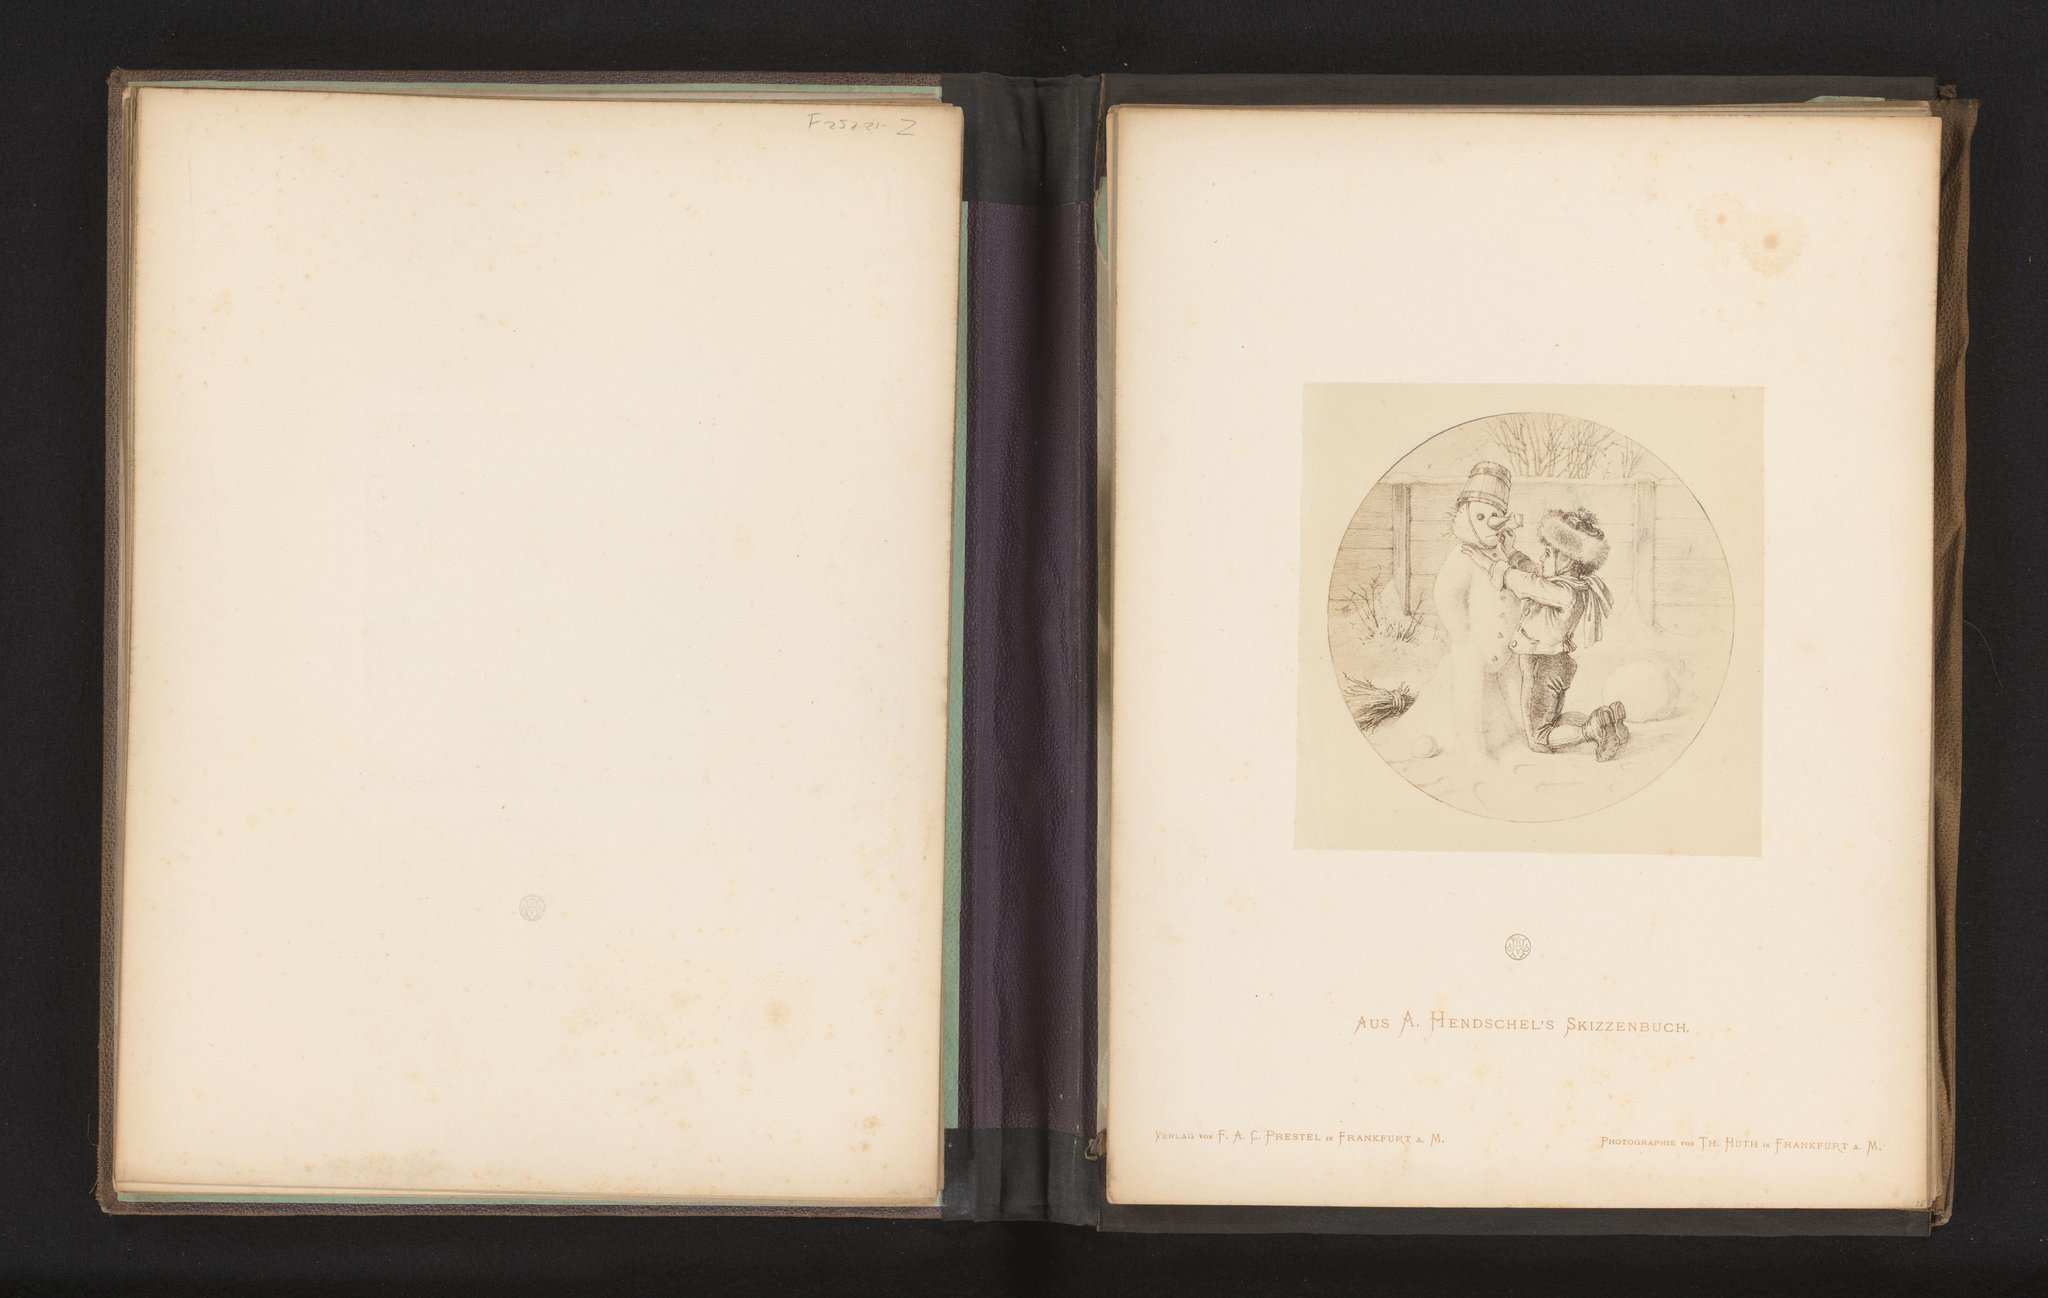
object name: photograph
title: Fotoreproductie van een schets van een jongen die een sneeuwpop maakt, door Albert Hendschel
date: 1865-1870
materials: paper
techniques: albumen print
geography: frankfurt am main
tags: (making a) snowman, toddler (male)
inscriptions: monogram: ‘AH’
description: Deze foto maakt deel uit van een omslag met 50 foto's op 48 bladen, een lijst van afbeeldingen en een titelblad.